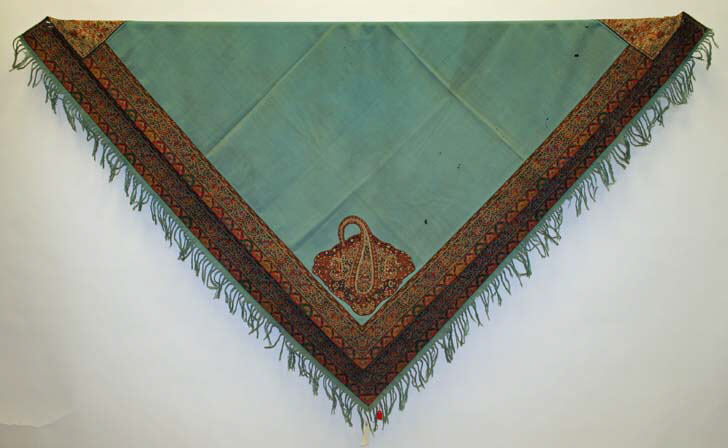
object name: scarf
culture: american or european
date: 1700-1938